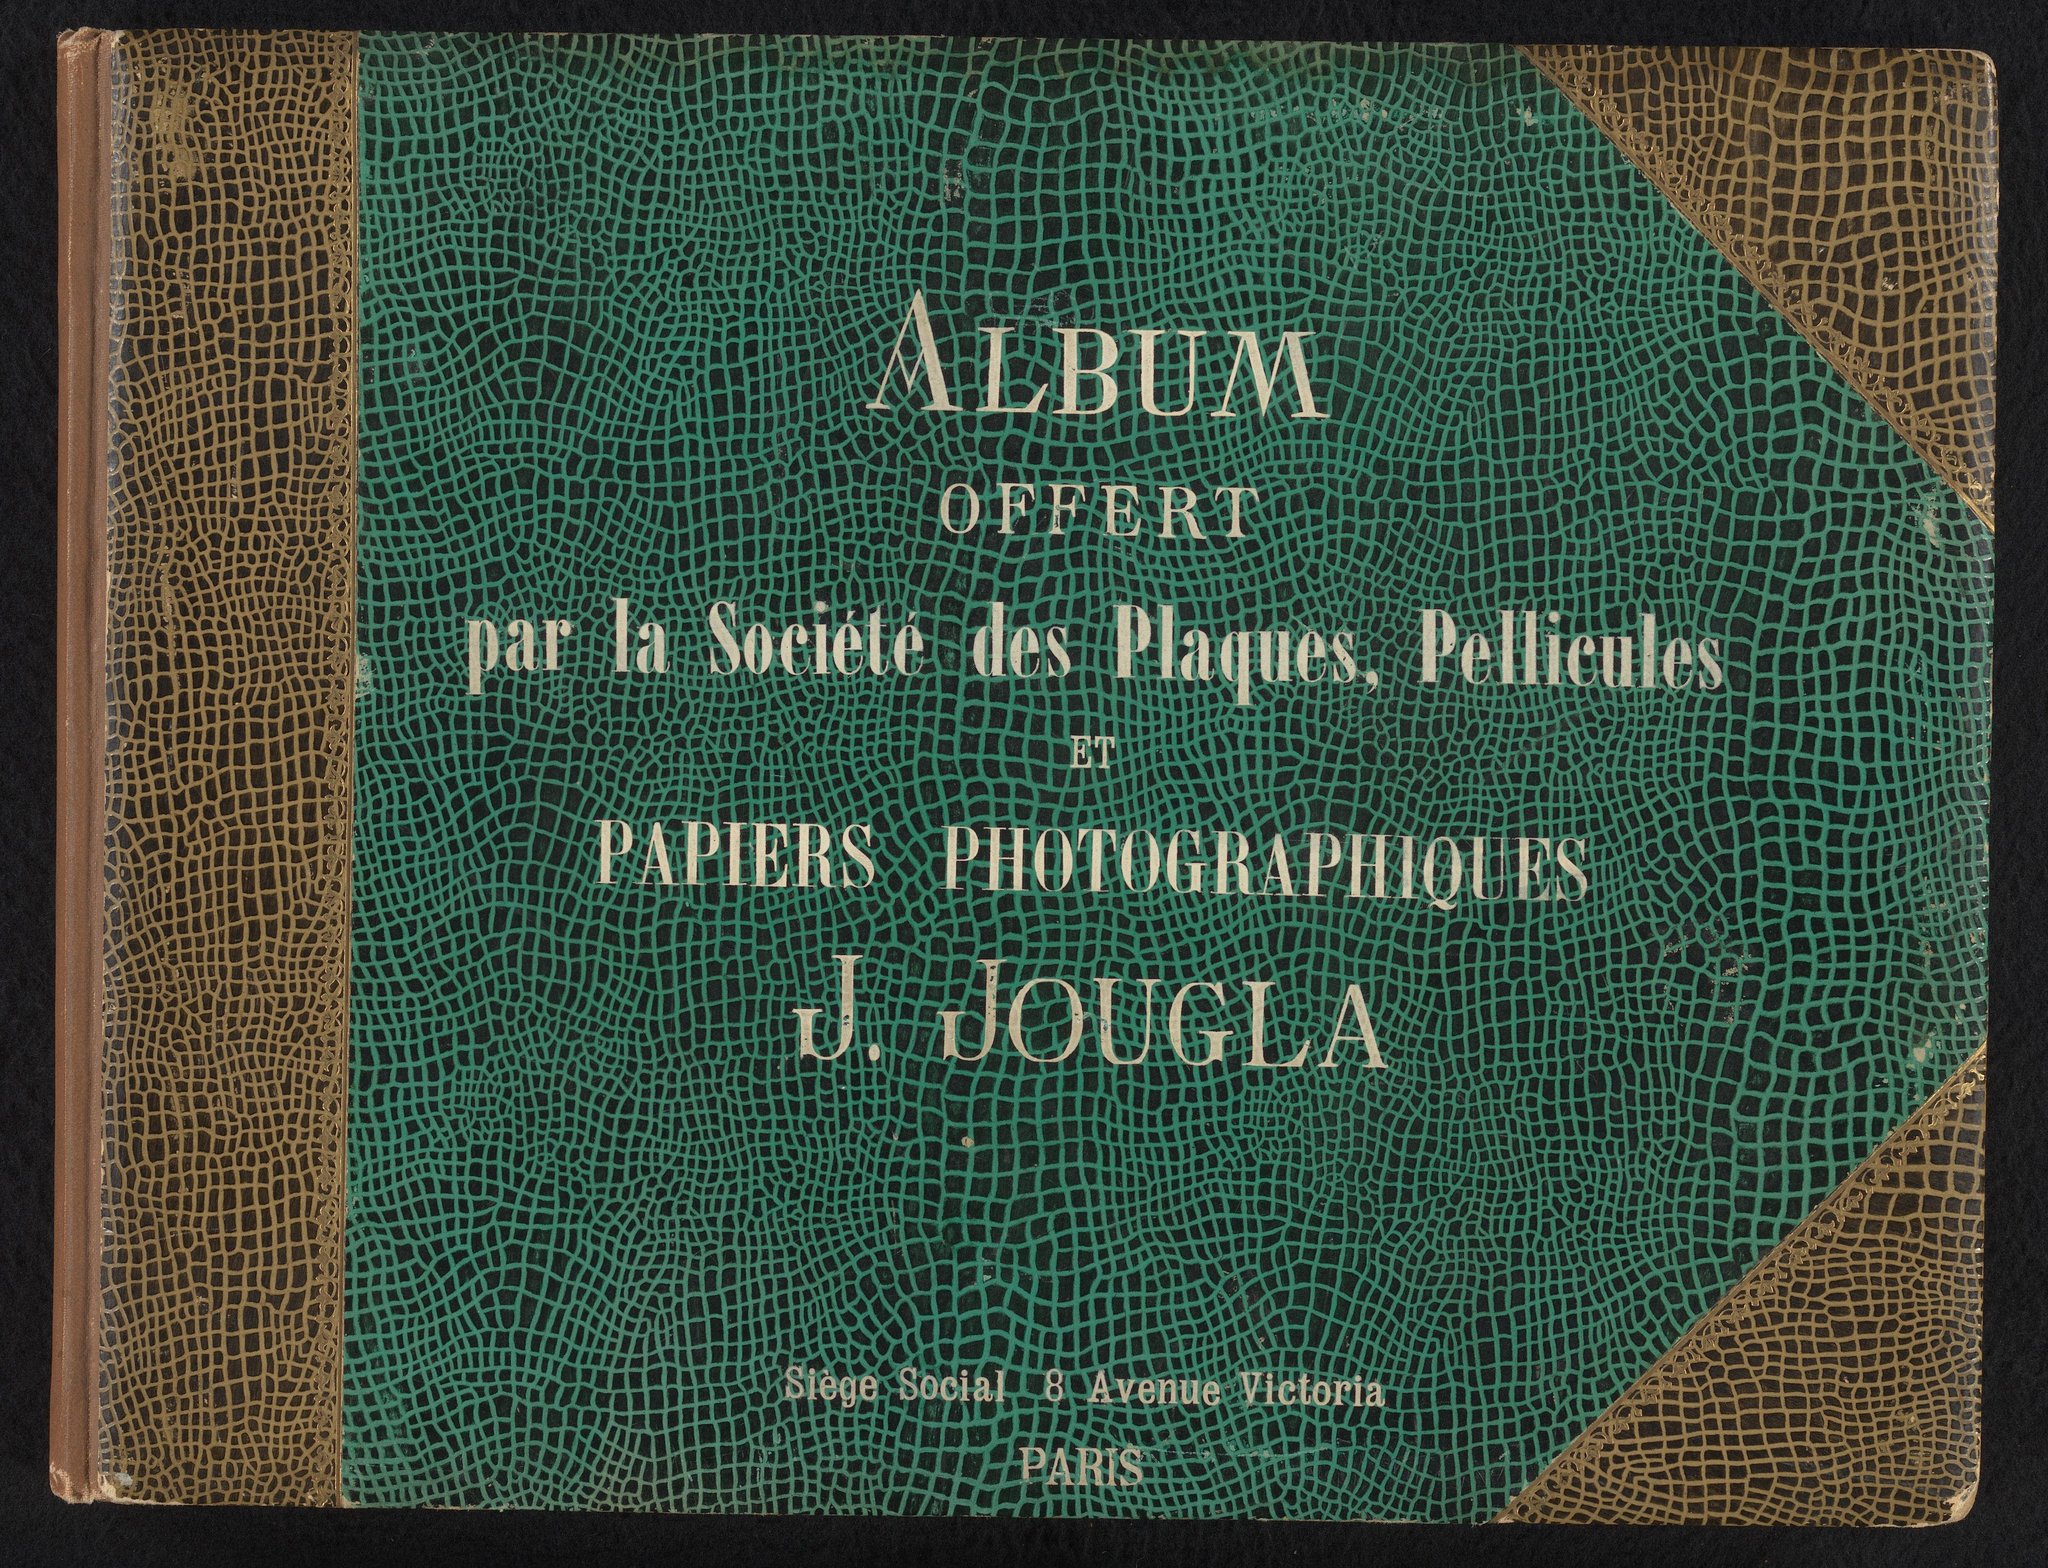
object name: book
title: Album offert par la société des plaques, pellicules et papiers photographiques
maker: j. jougla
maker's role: manufacturer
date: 1895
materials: cardboard, leather, paper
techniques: gelatin silver print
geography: paris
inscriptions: number: ‘€120’, address: ‘Siége Social 8 Avenue Victoria/ PARIS’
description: Fotoboek met 22 foto's op 12 pagina's van verschillende technieken als reclame voor het bedrijf van fotofabrikant J. Jougla.